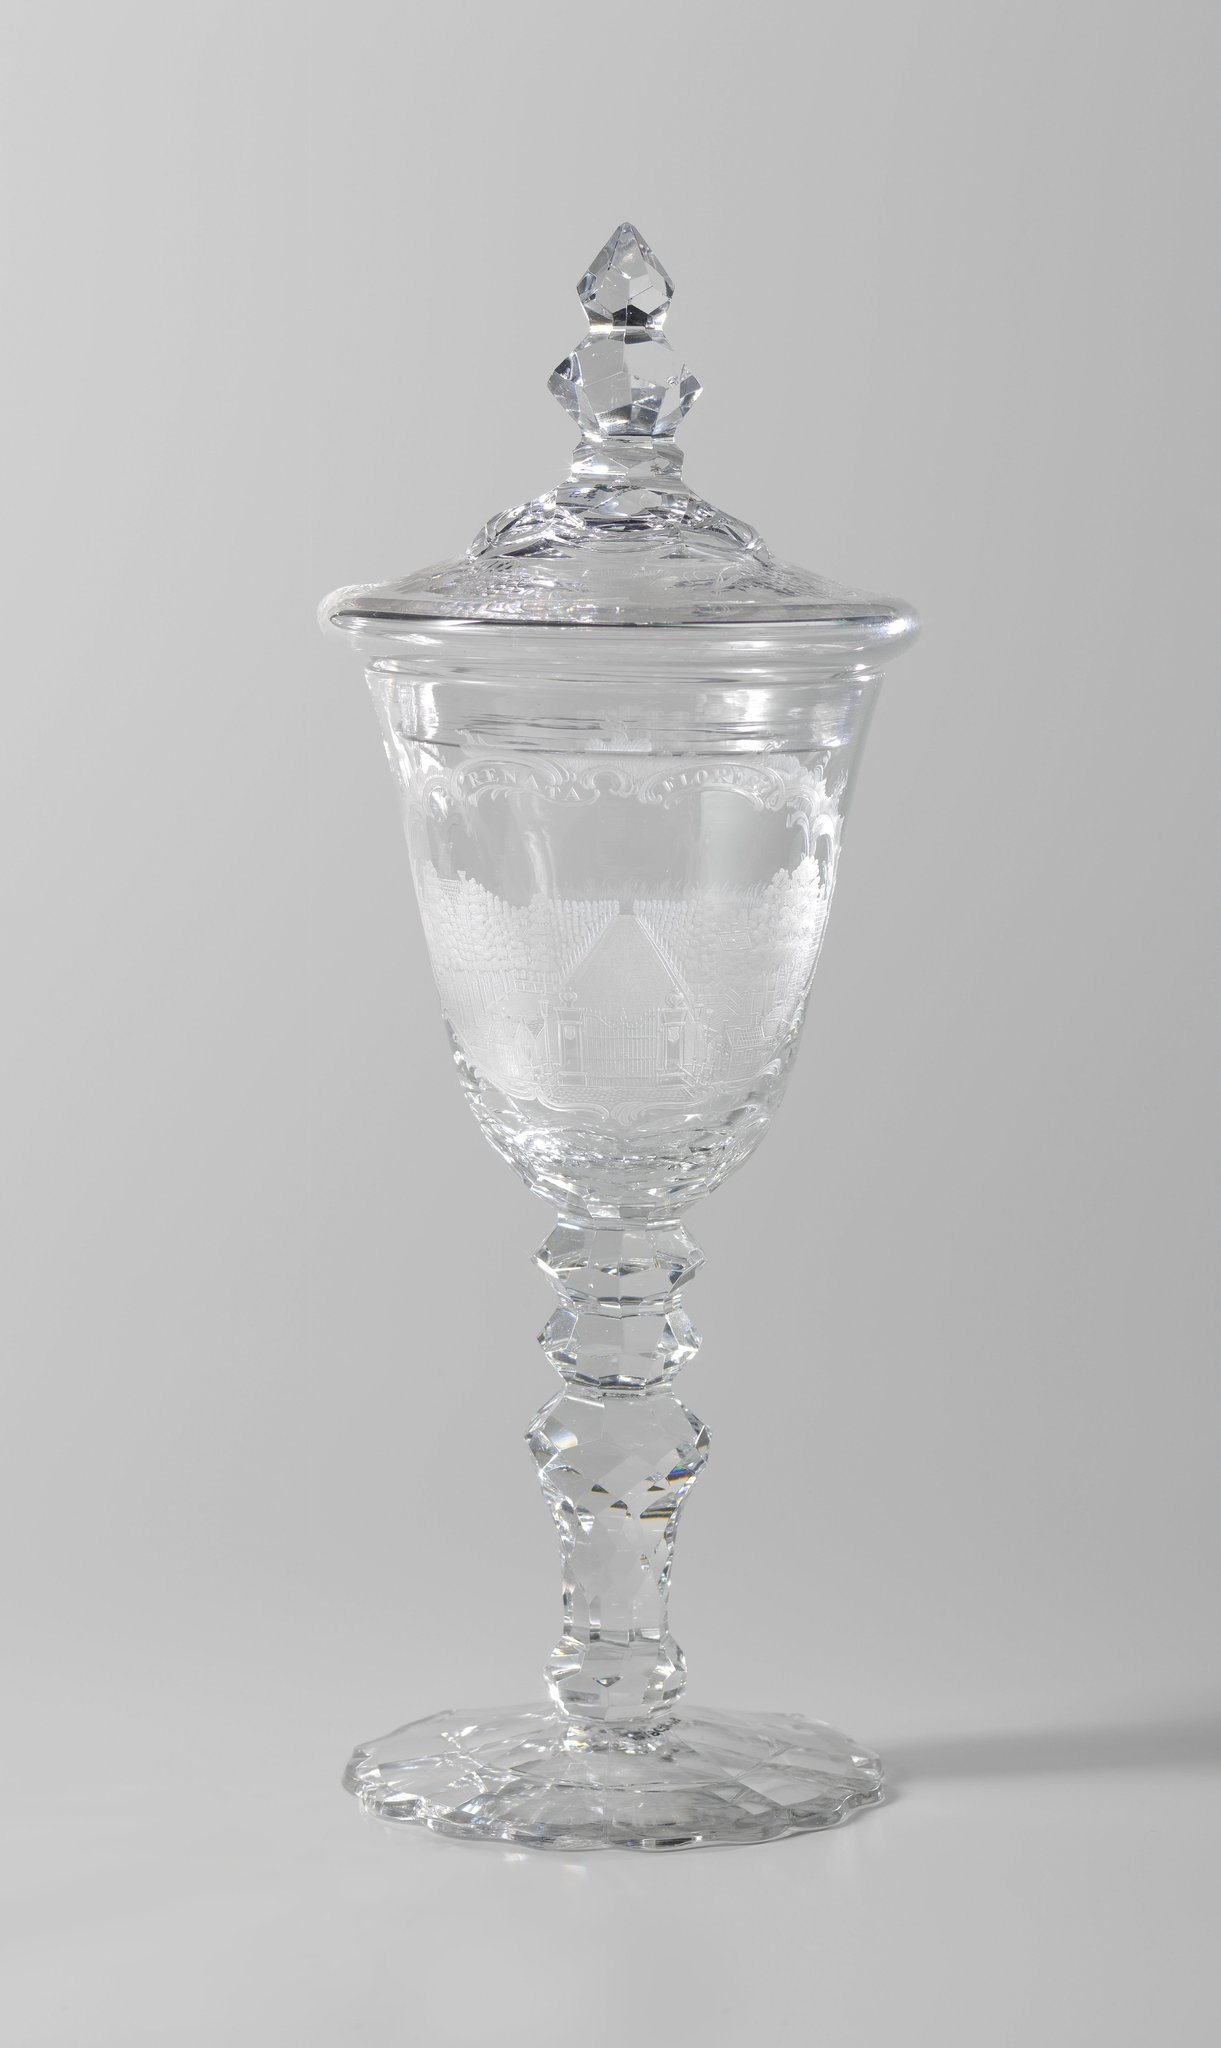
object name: goblet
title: Bokaal met deksel, met de Middelweg (de huidige Middenweg) te Diemen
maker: simon jacob sang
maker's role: glasgraveur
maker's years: 1720-1786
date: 1768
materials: glass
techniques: glassblowing, grinding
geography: amsterdam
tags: amsterdam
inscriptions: signature and date: ‘Jacob Sang, // Fec: Amsterdam // 1768’, inscription: ‘RENATA FLOREAT EX UNDIS’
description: Wheel engraved glasses, by Jacob Sang (c. 1725 - 1785) and Simon Jacob Sang (c. 1720 - 1786), both active in Amsterdam, between c. 1750 - 1780. Nos. 1- 3 by Jacob Sang, no. 4 and 5 by Simon Jacob Sang: 1. Coat of arms of the United Provinces, 1760; 2.Plantations Schravenhagen and Alida in Surinam, c. 1752 - 1775 ; 3.View of the Nieuwe Kerk, Amsterdam, 1760. On loan from the Koninklijk Oudheidkundig Genootschap. ; 4.View of Middelweg in Diemen near Amsterdam, 1768. On loan from the Koninklijk Oudheidkundig Genootschap. ; 5. Manor house Leyduin near Heemstede, 1752.